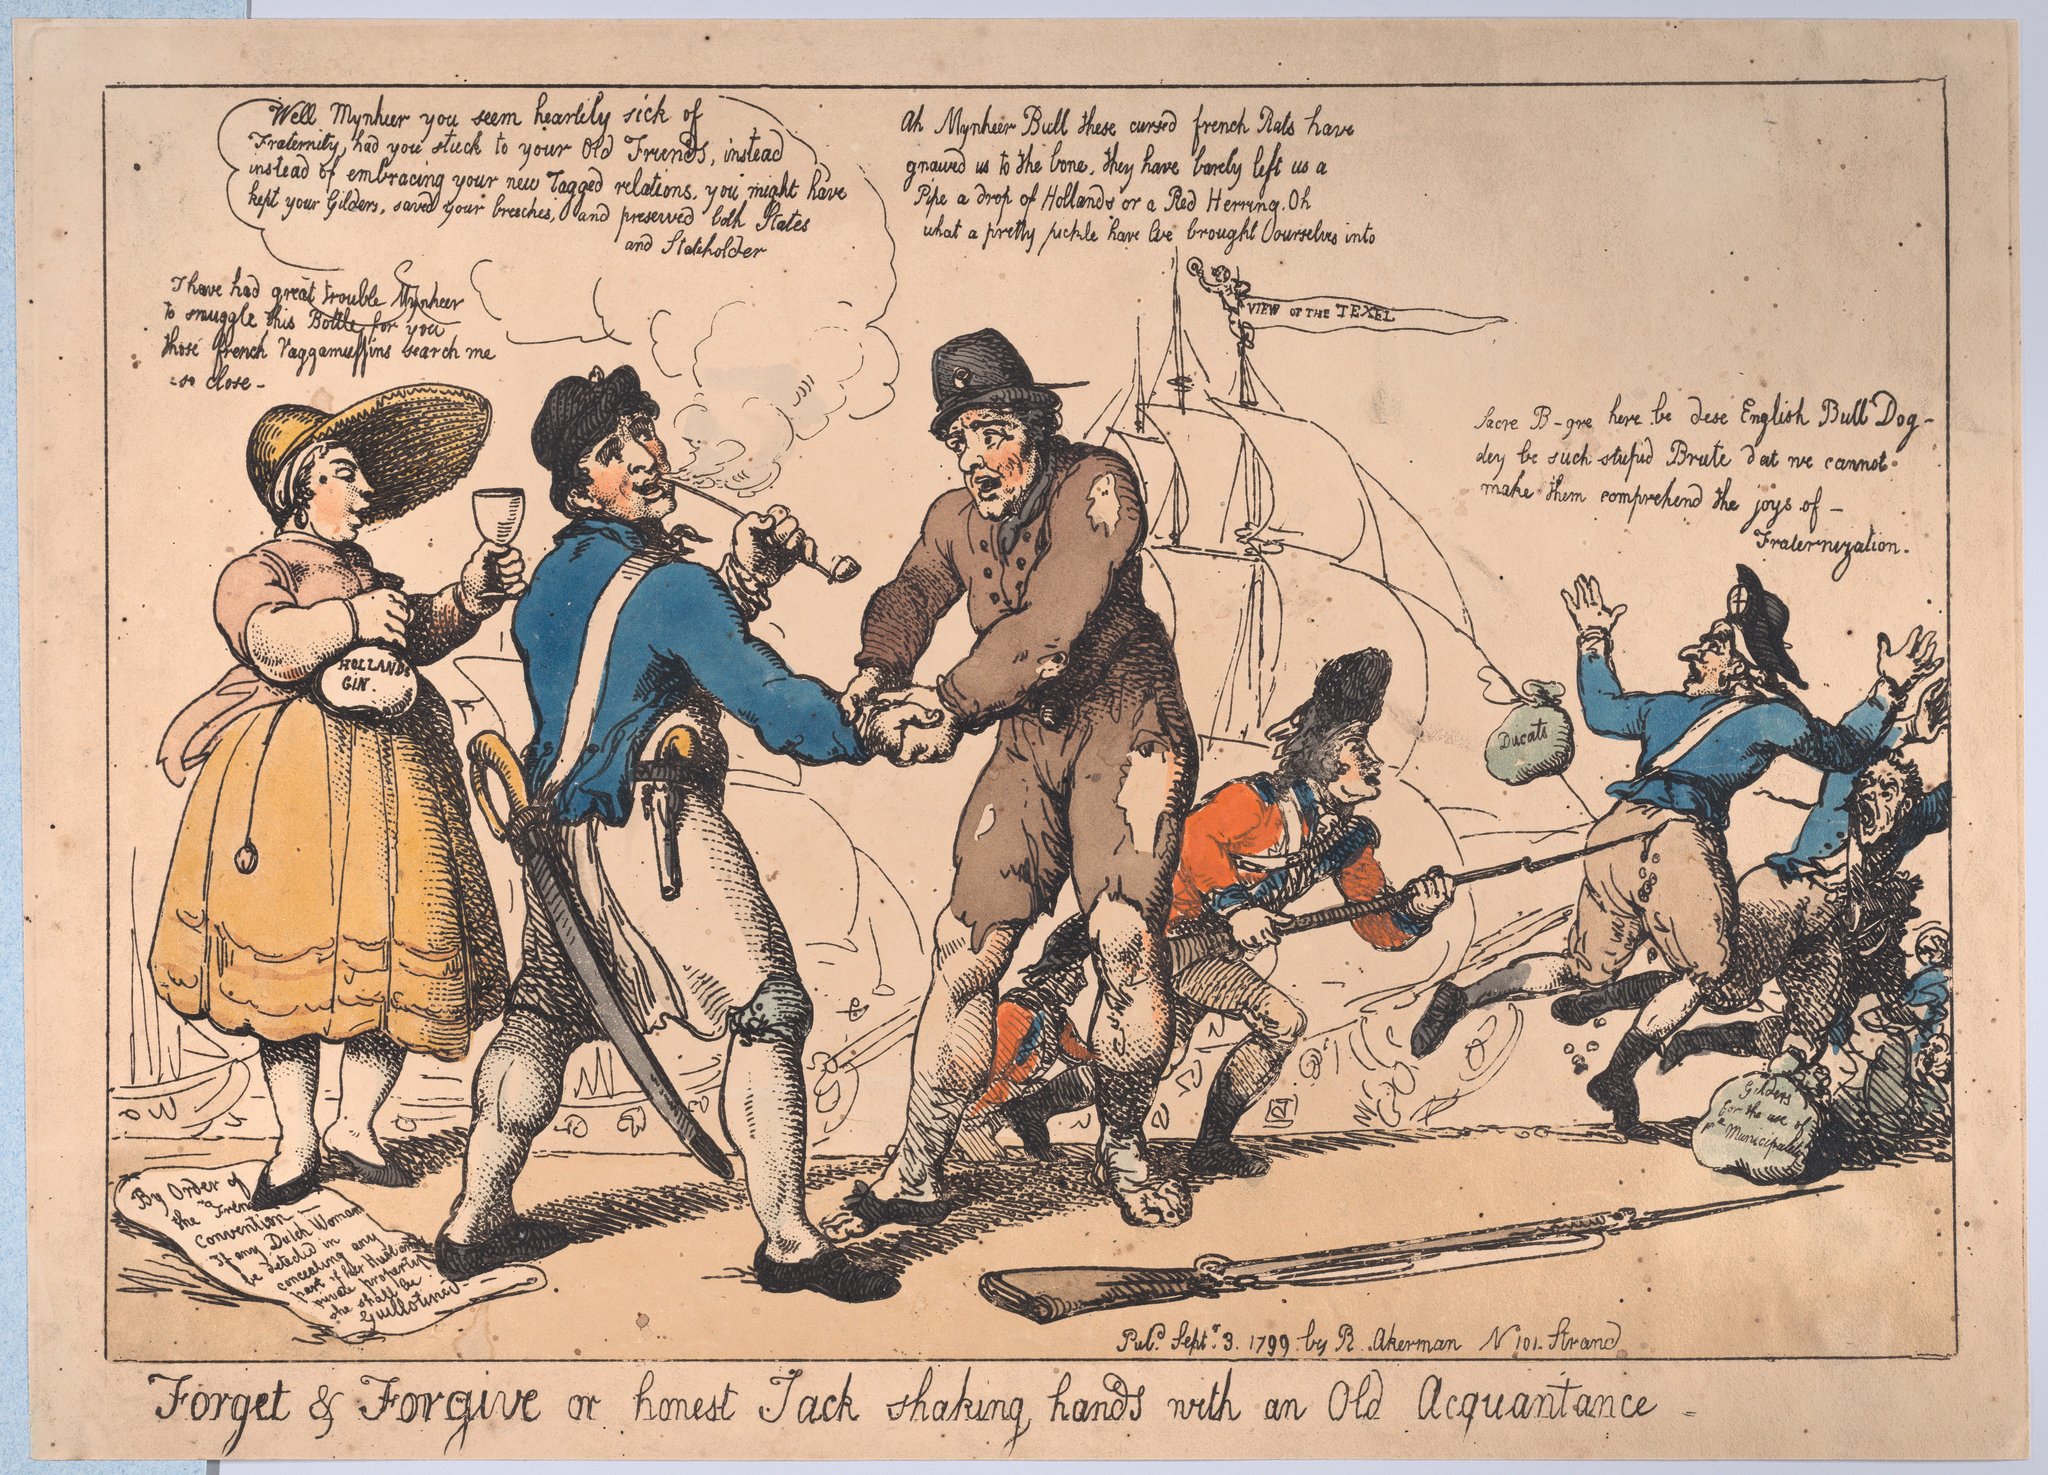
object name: print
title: Forget & Forgive, or Honest Jack Shaking Hands with and Old Acquaintance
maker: thomas rowlandson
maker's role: artist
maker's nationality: british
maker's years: 1757-1827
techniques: etching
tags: satire,soldiers,men,women,smoking,drinking